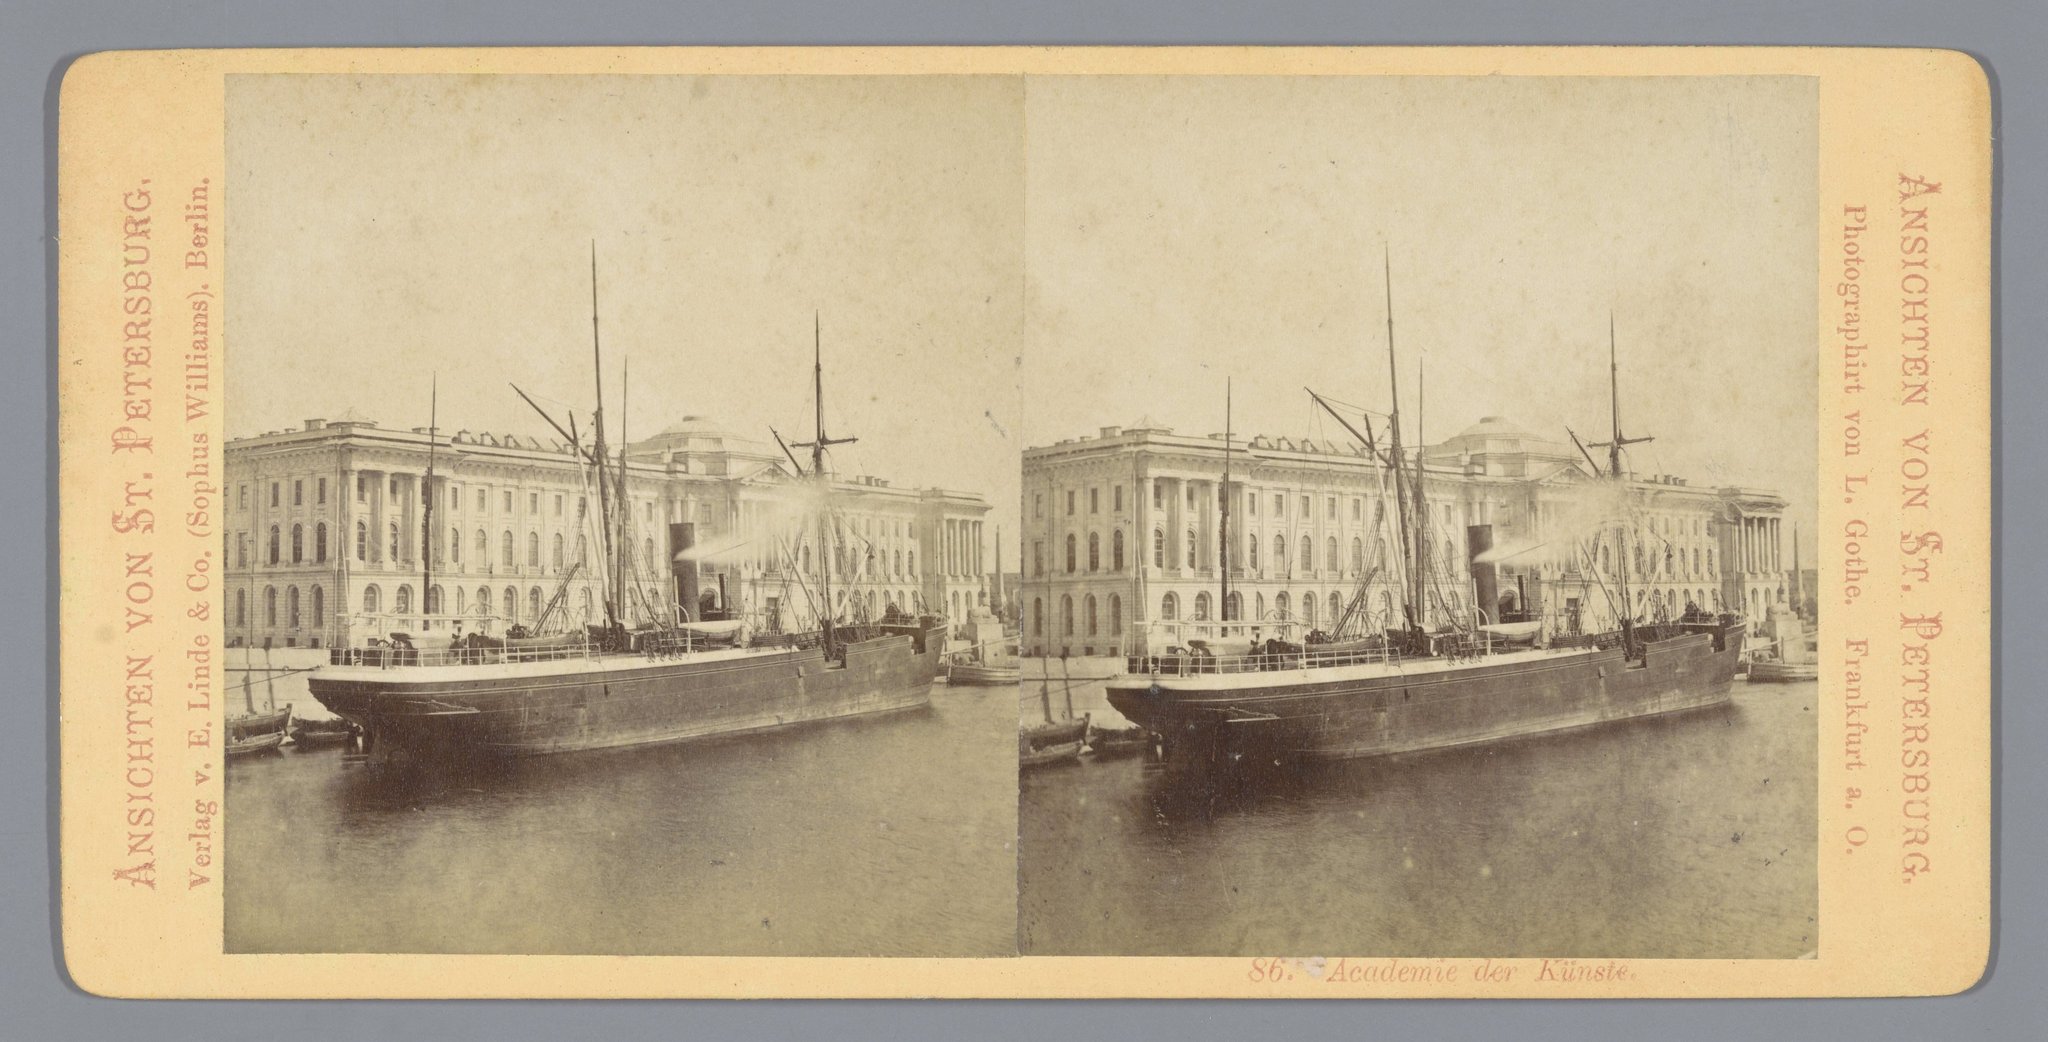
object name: stereograph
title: Academie der Künste.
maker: louis gothe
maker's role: fotograaf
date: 1850-1880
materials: cardboard, photographic support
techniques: albumen print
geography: sint-petersburg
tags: ships (in general), quay, place or institution of education and training of the artist, e.g.: academy of art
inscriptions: inscription: ‘Ansichten von St. Petersburg.’, number: ‘86.’